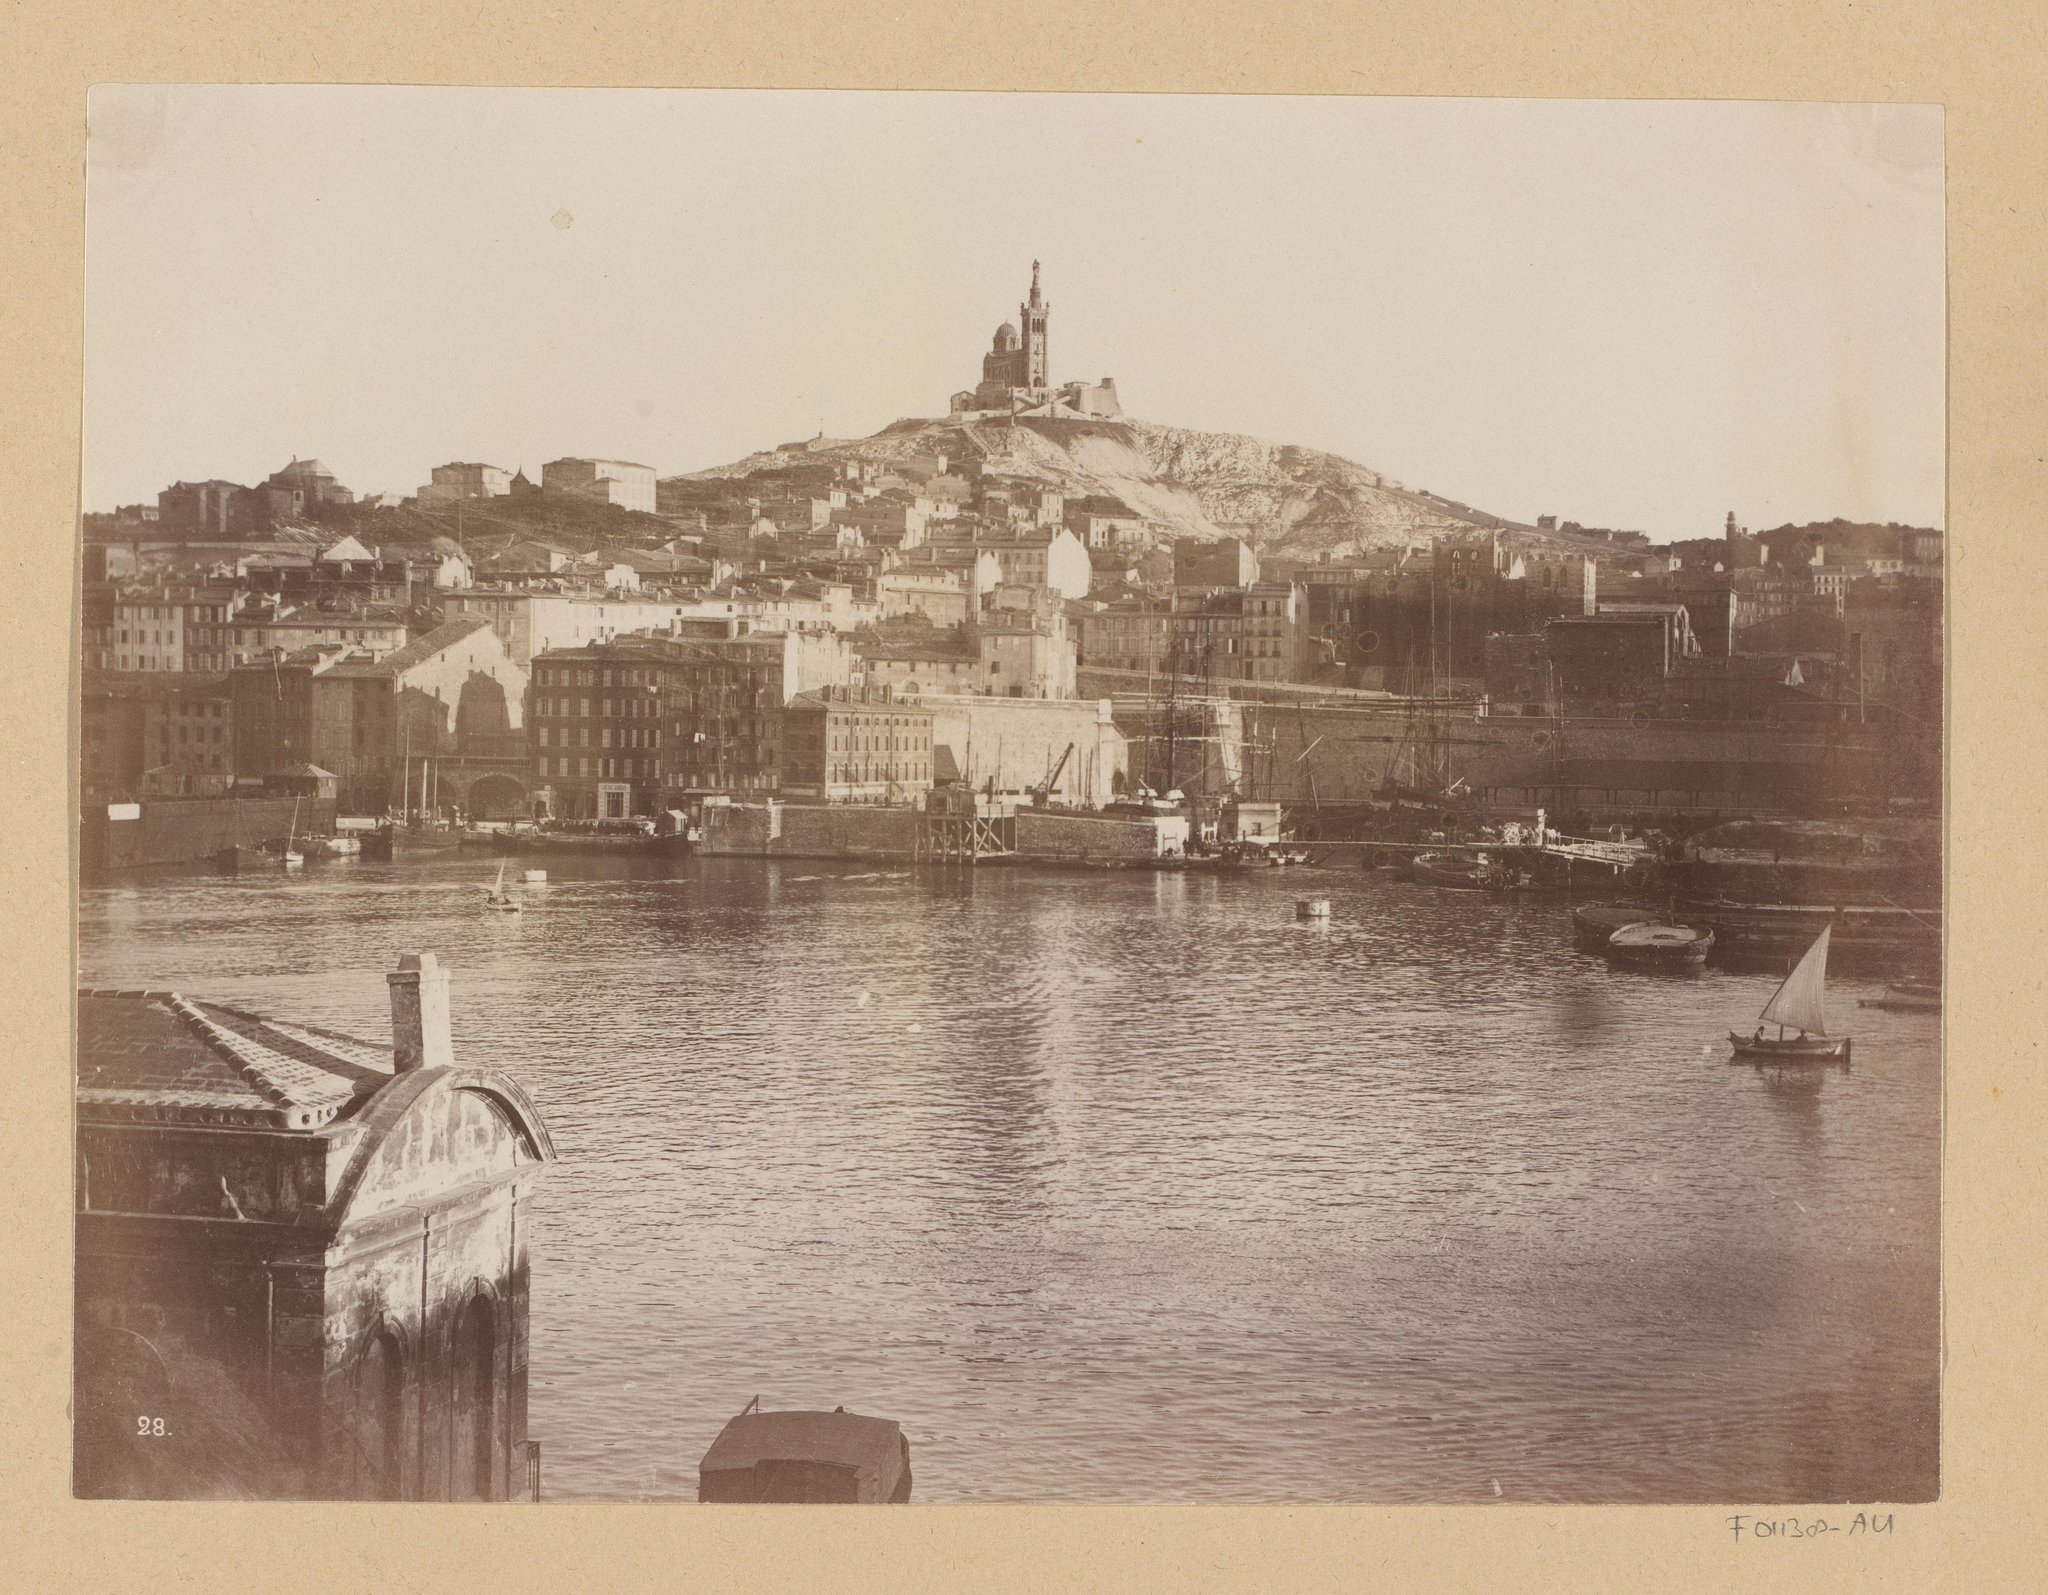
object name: photograph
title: Gezicht op de haven en Notre-Dame-de-la-Garde in Marseille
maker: Anonymous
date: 1860-1900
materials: photographic support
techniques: albumen print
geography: marseille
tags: harbour, church (exterior), marseille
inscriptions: number: ‘28’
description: Onderdeel van Reisalbum met opnames van kunstwerken en bezienswaardigheden in Italië, Griekenland en Frankrijk.